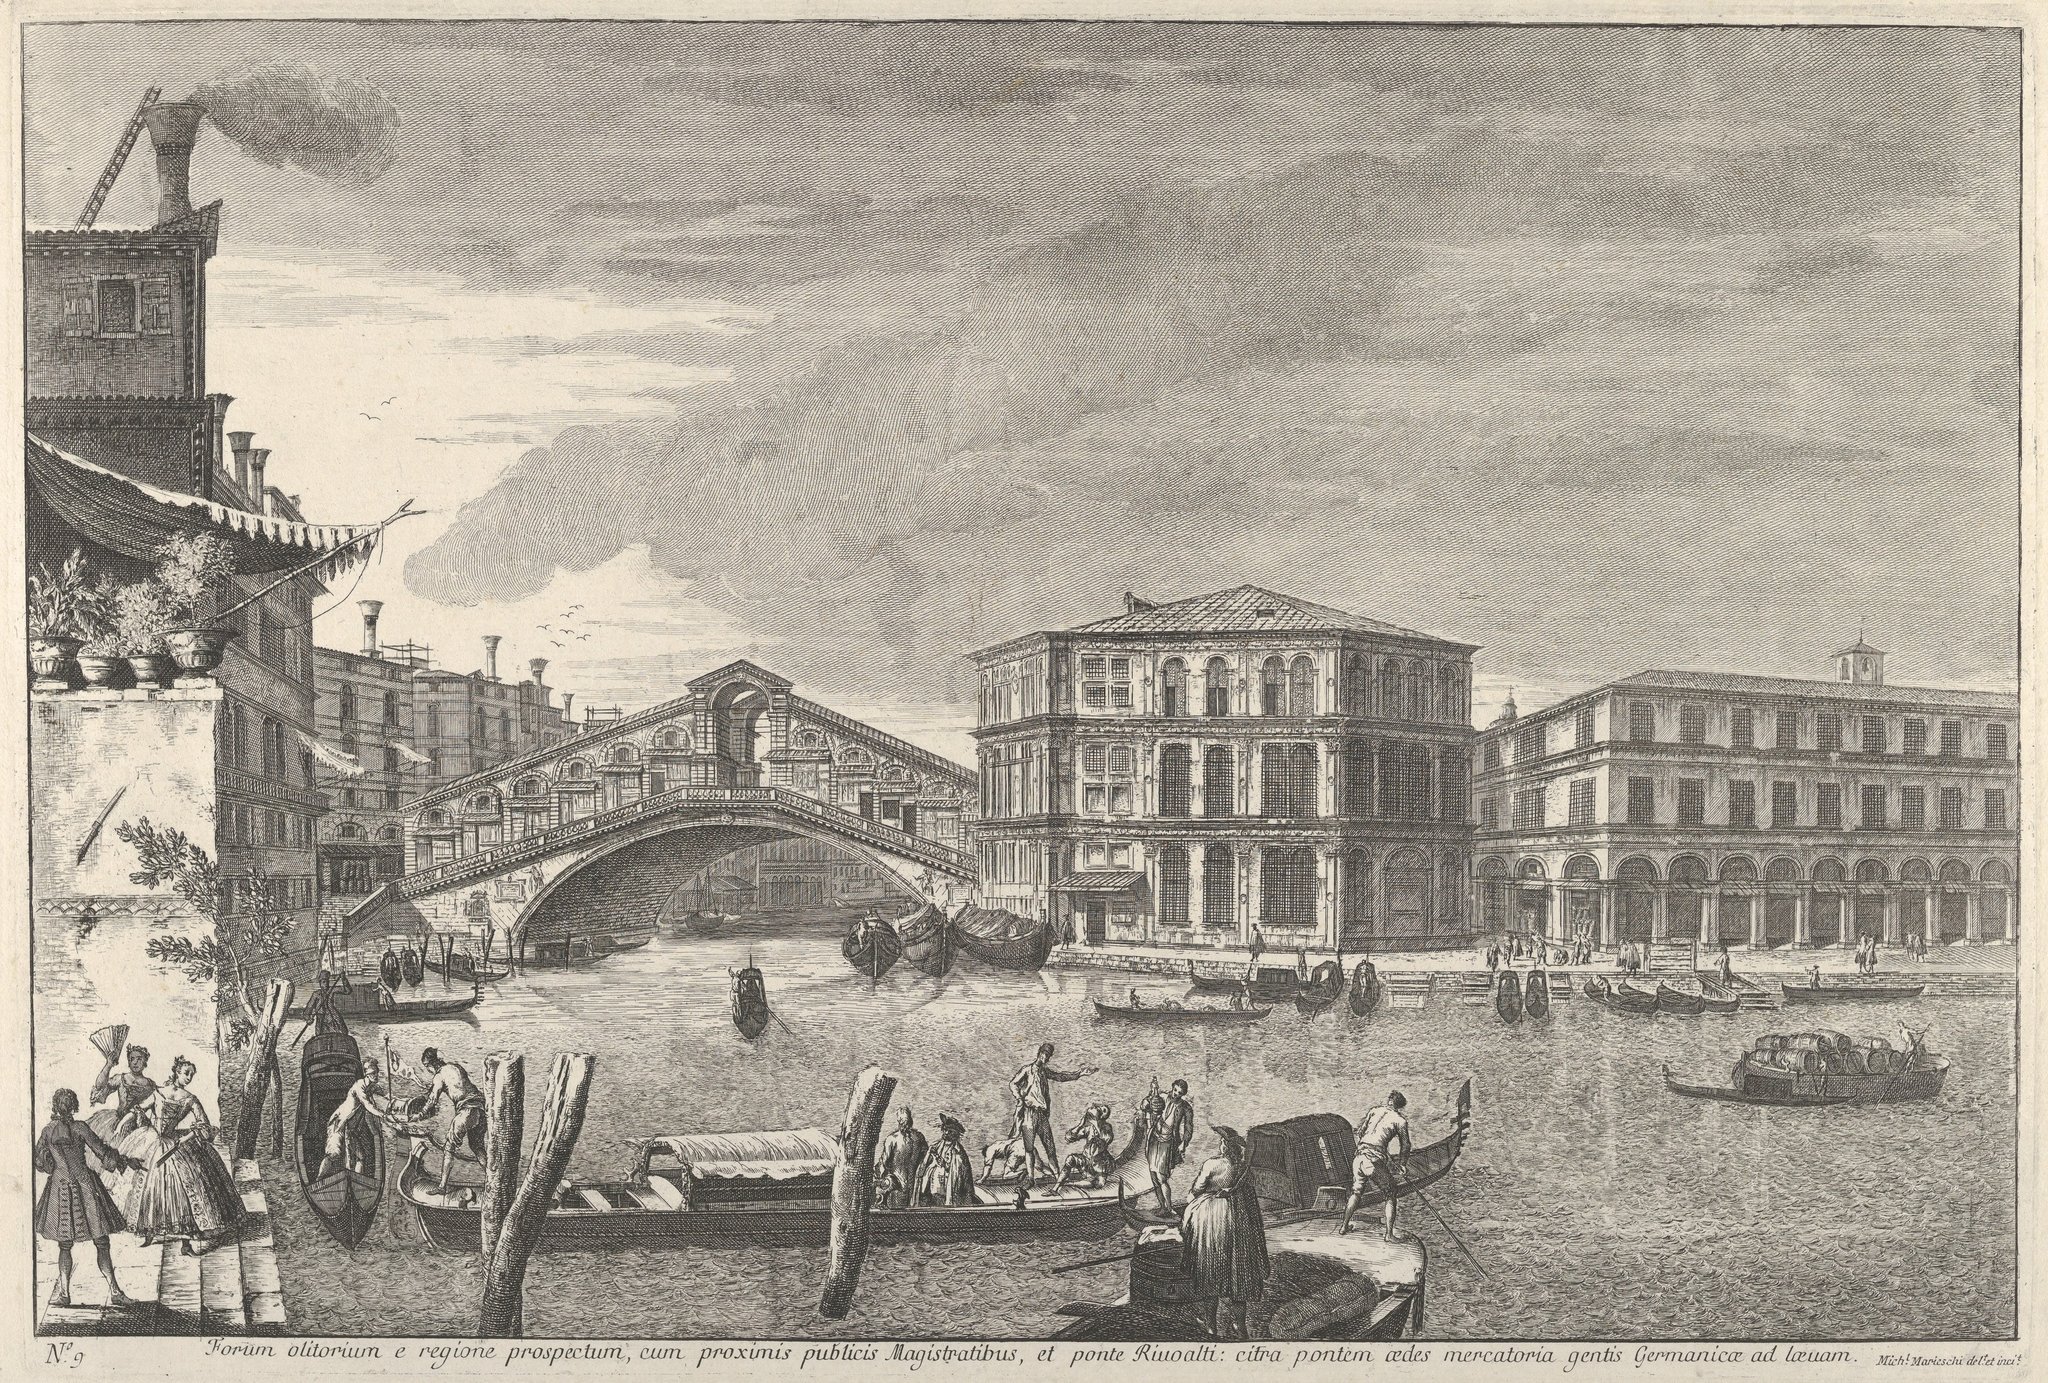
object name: print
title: Plate 9: The bridge and market of the Rialto, Venice, from "Views of Venice" (Magnificentiores Selectioresque Urbis Venetiarum Prospectus)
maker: michele marieschi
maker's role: artist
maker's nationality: italian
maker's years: 1710-1743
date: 1741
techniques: etching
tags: bridges,canals,boats,venice